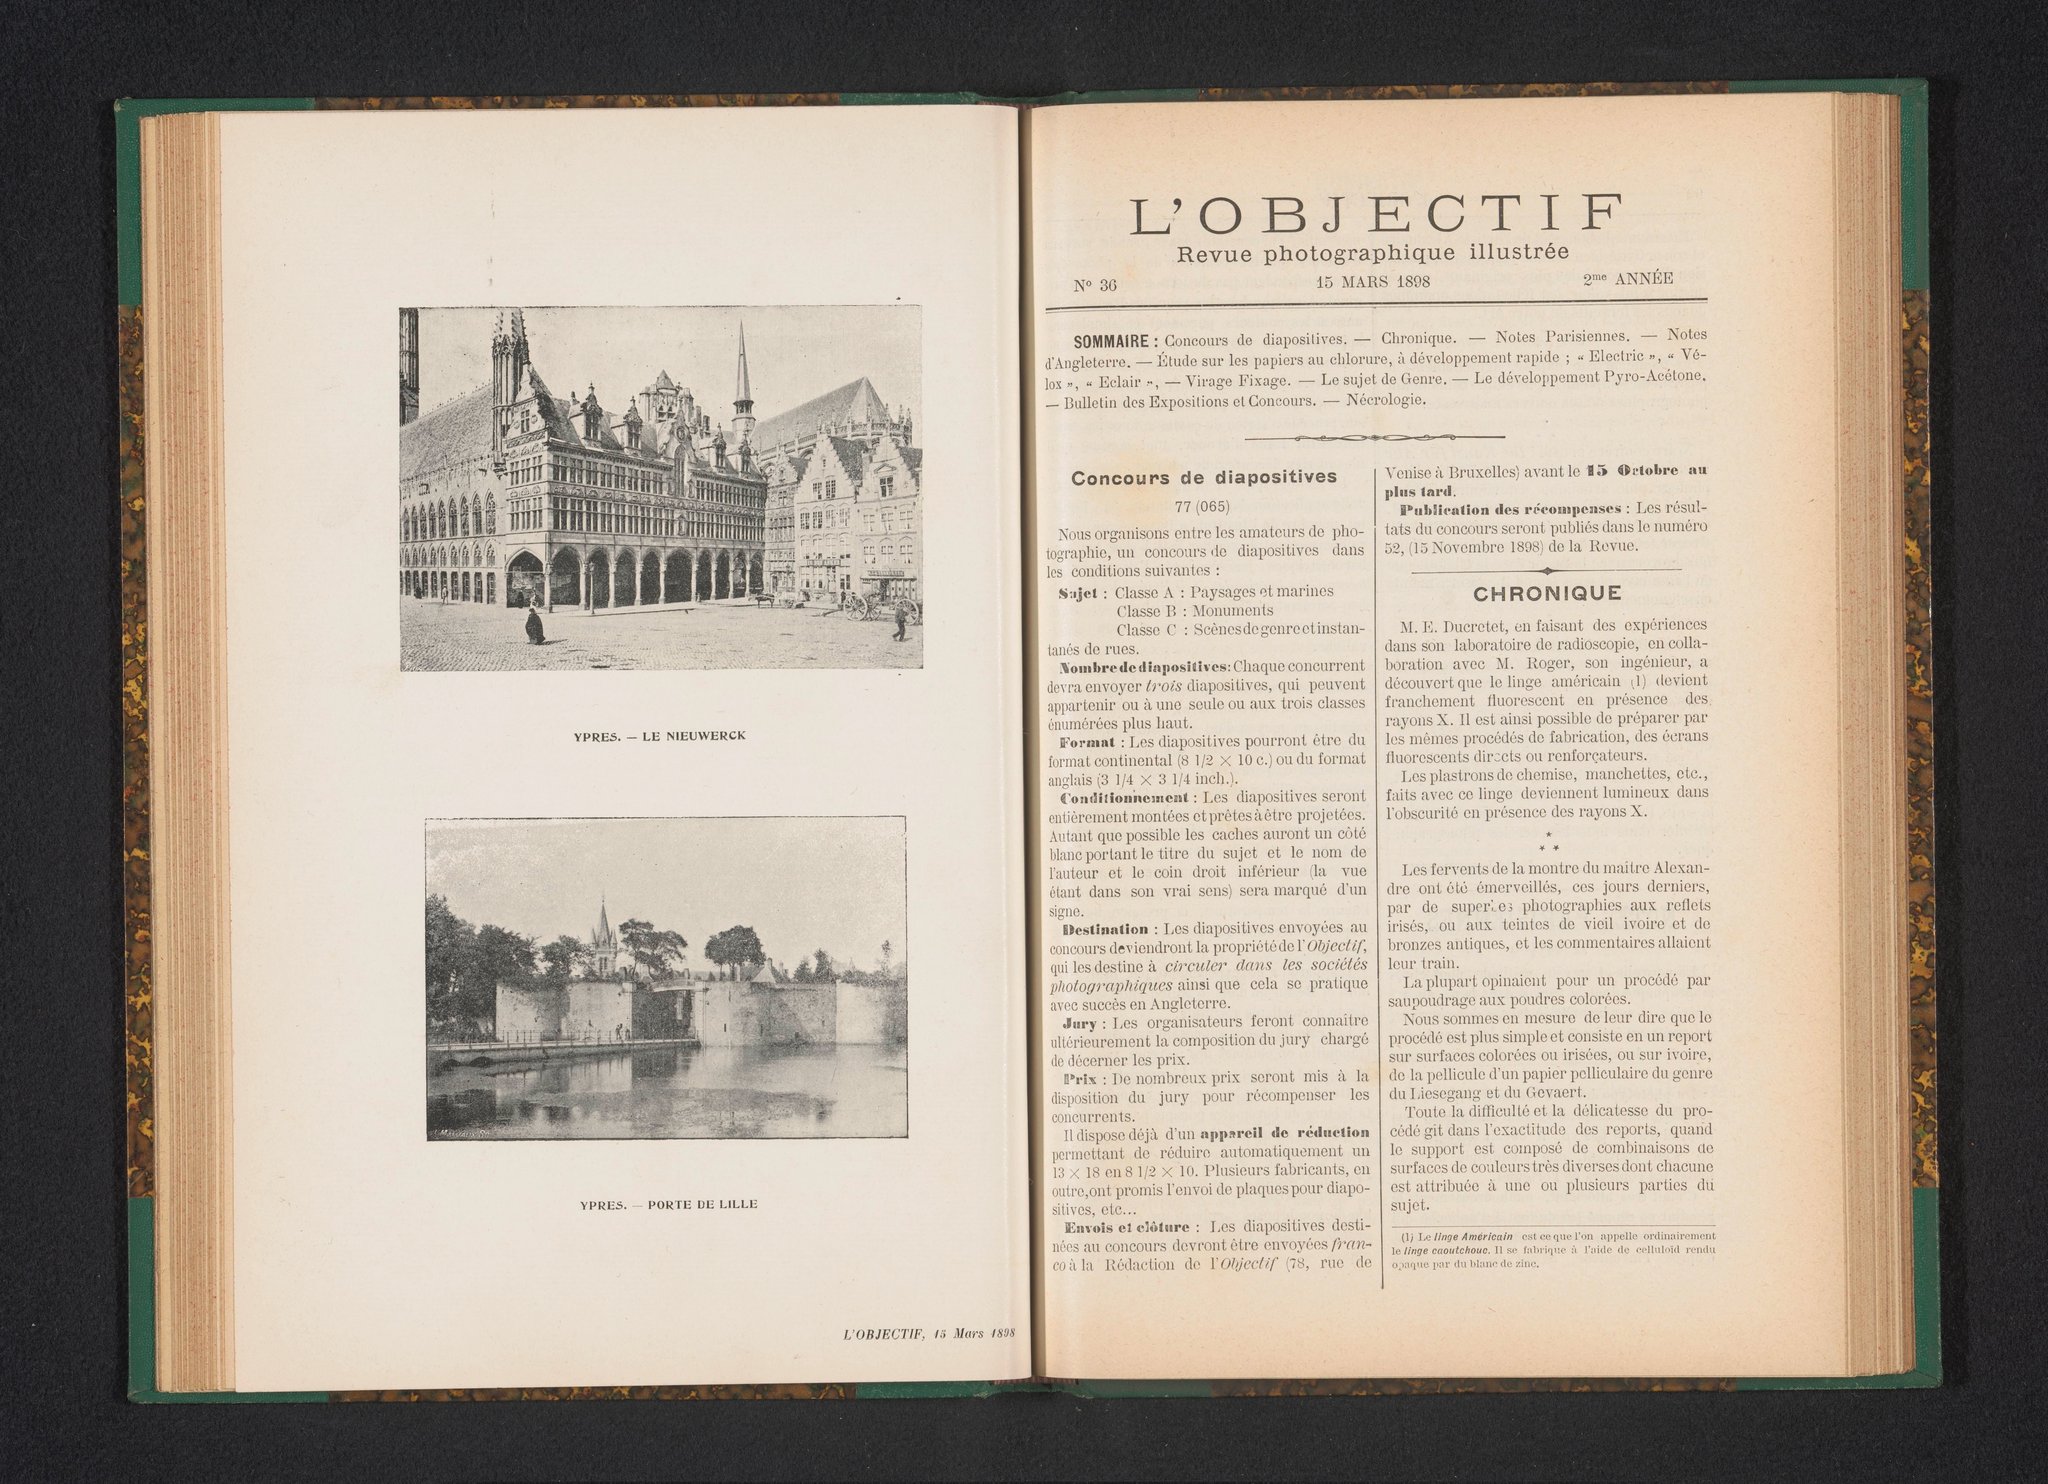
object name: photomechanical print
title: Ypres. Porte de Lille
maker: jean malvaux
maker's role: printer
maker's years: 1839-1903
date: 1896-1900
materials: paper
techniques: autotype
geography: ieper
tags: city-view in general; 'veduta'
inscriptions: inscription: ‘L'objectif, 15 Mars 1898’